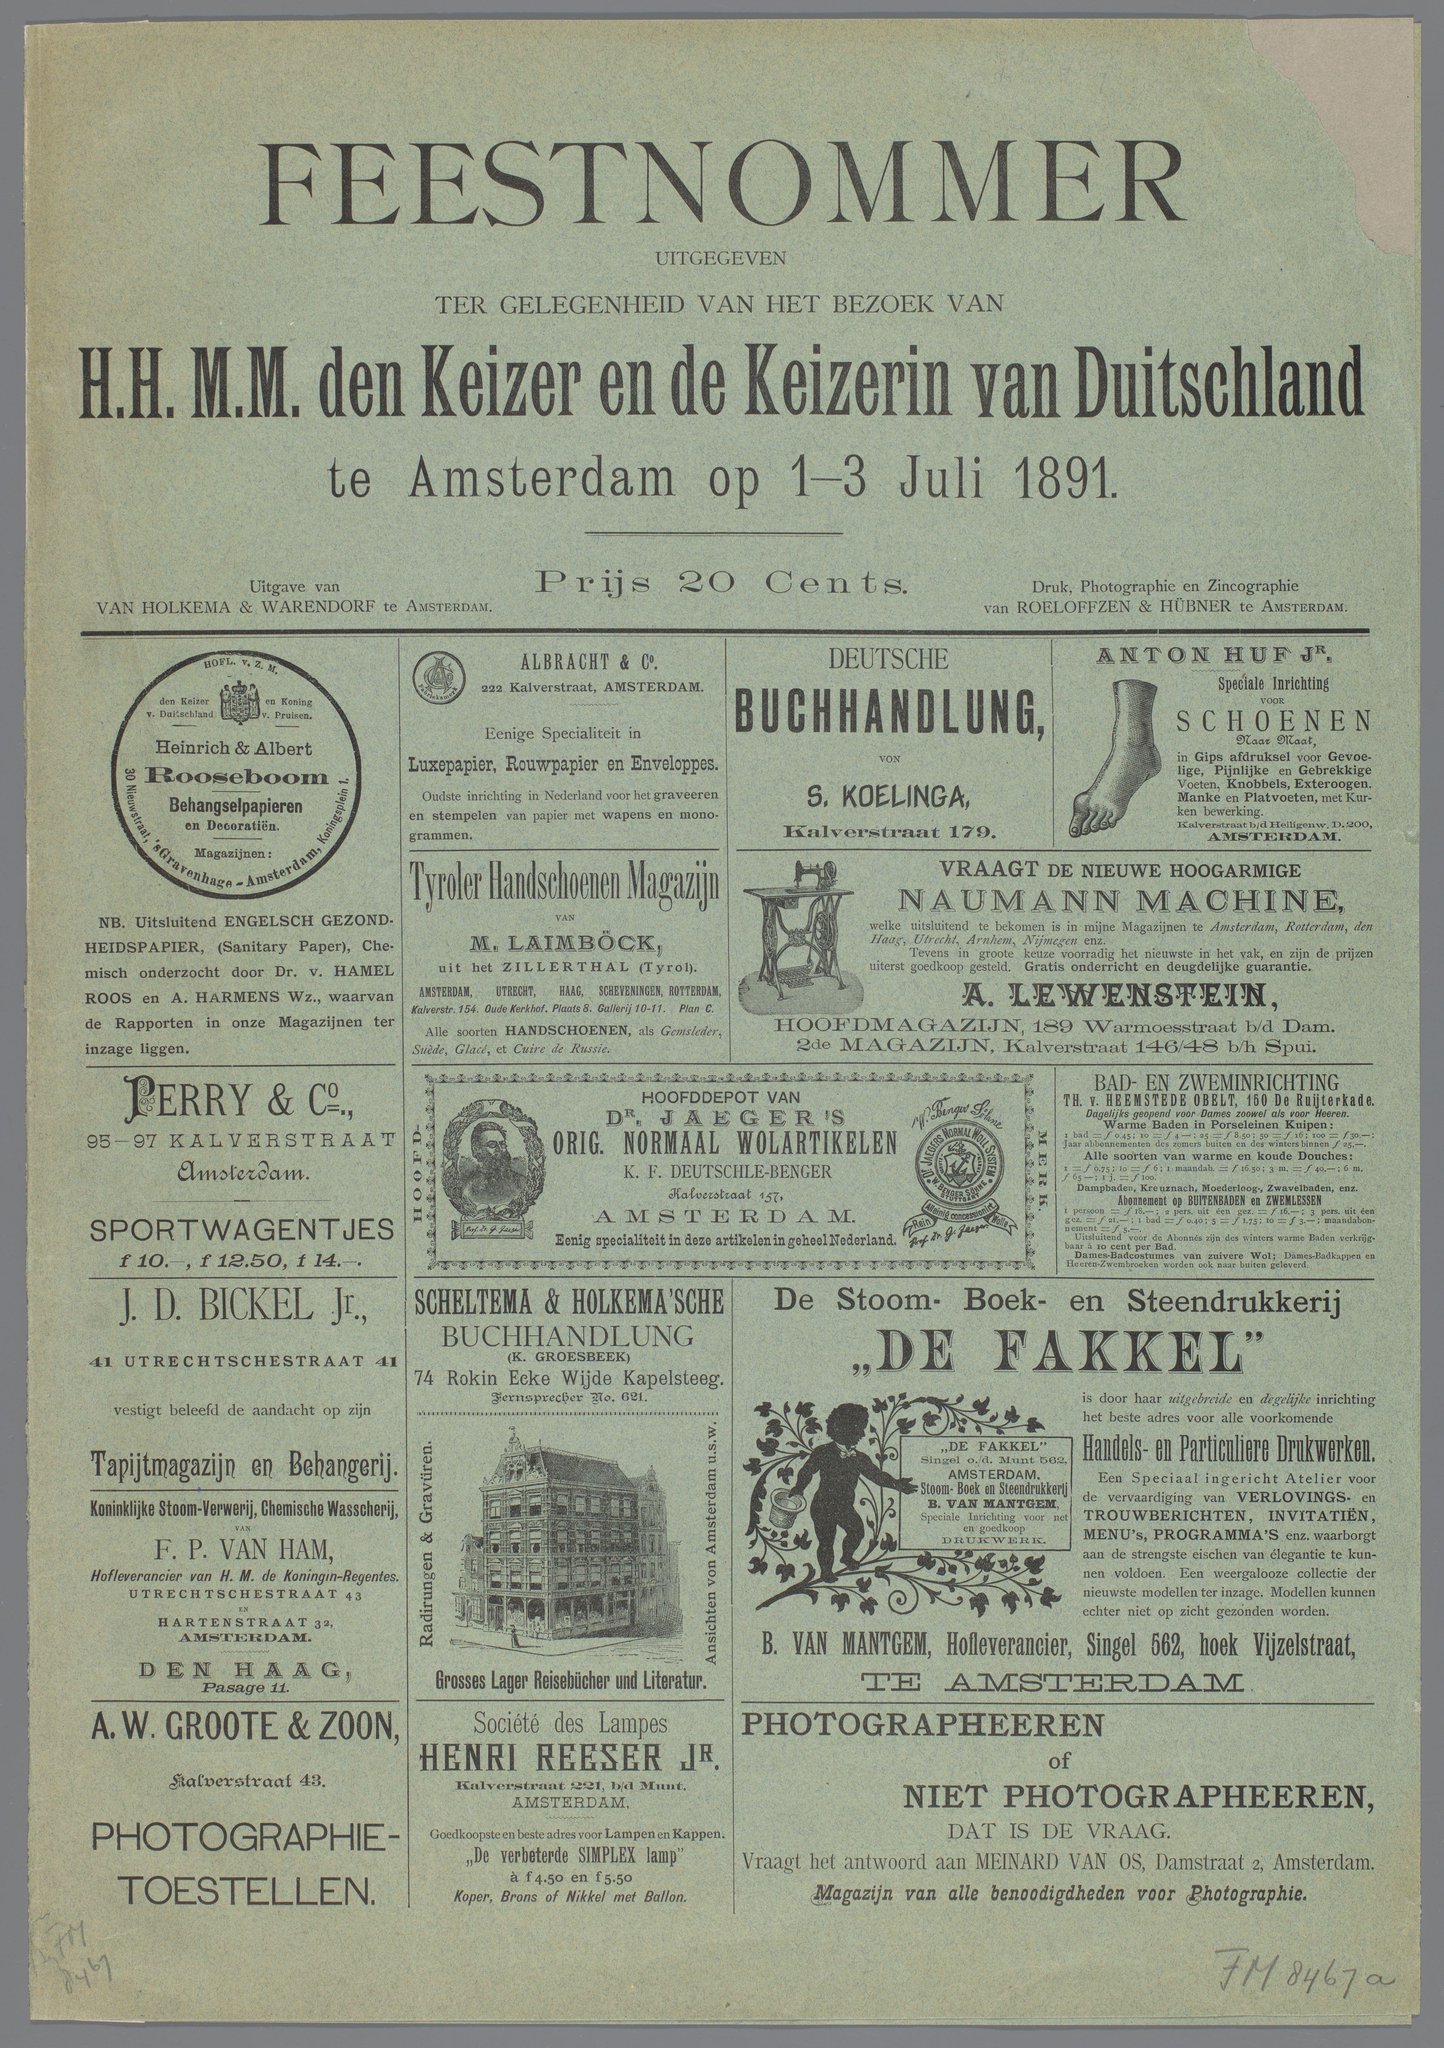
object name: print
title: Feestnommer uitgegeven ter gelegenheid van het bezoek van H.H.M.M. den Keizer en de Keizerin van Duitschland te Amsterdam op 1-3 Juli 1891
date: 1807-1891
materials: paper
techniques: letterpress printing, engraving, lithography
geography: amsterdam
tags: wilhelm ii (keizer van duitsland), amsterdam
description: Blad uitgegeven ter gelegenheid van het bezoek van de keizer Wilhelm II van Duitsland en keizerin aan Amsterdam van 1-3 juli 1891.Omslag om het blad van groengrijs papier bedrukt op voor- en achterzijde met advertenties. Binnenin vier bladen met tekst en illustraties, bijgevoegd is het programmaboekje van het bezoek.